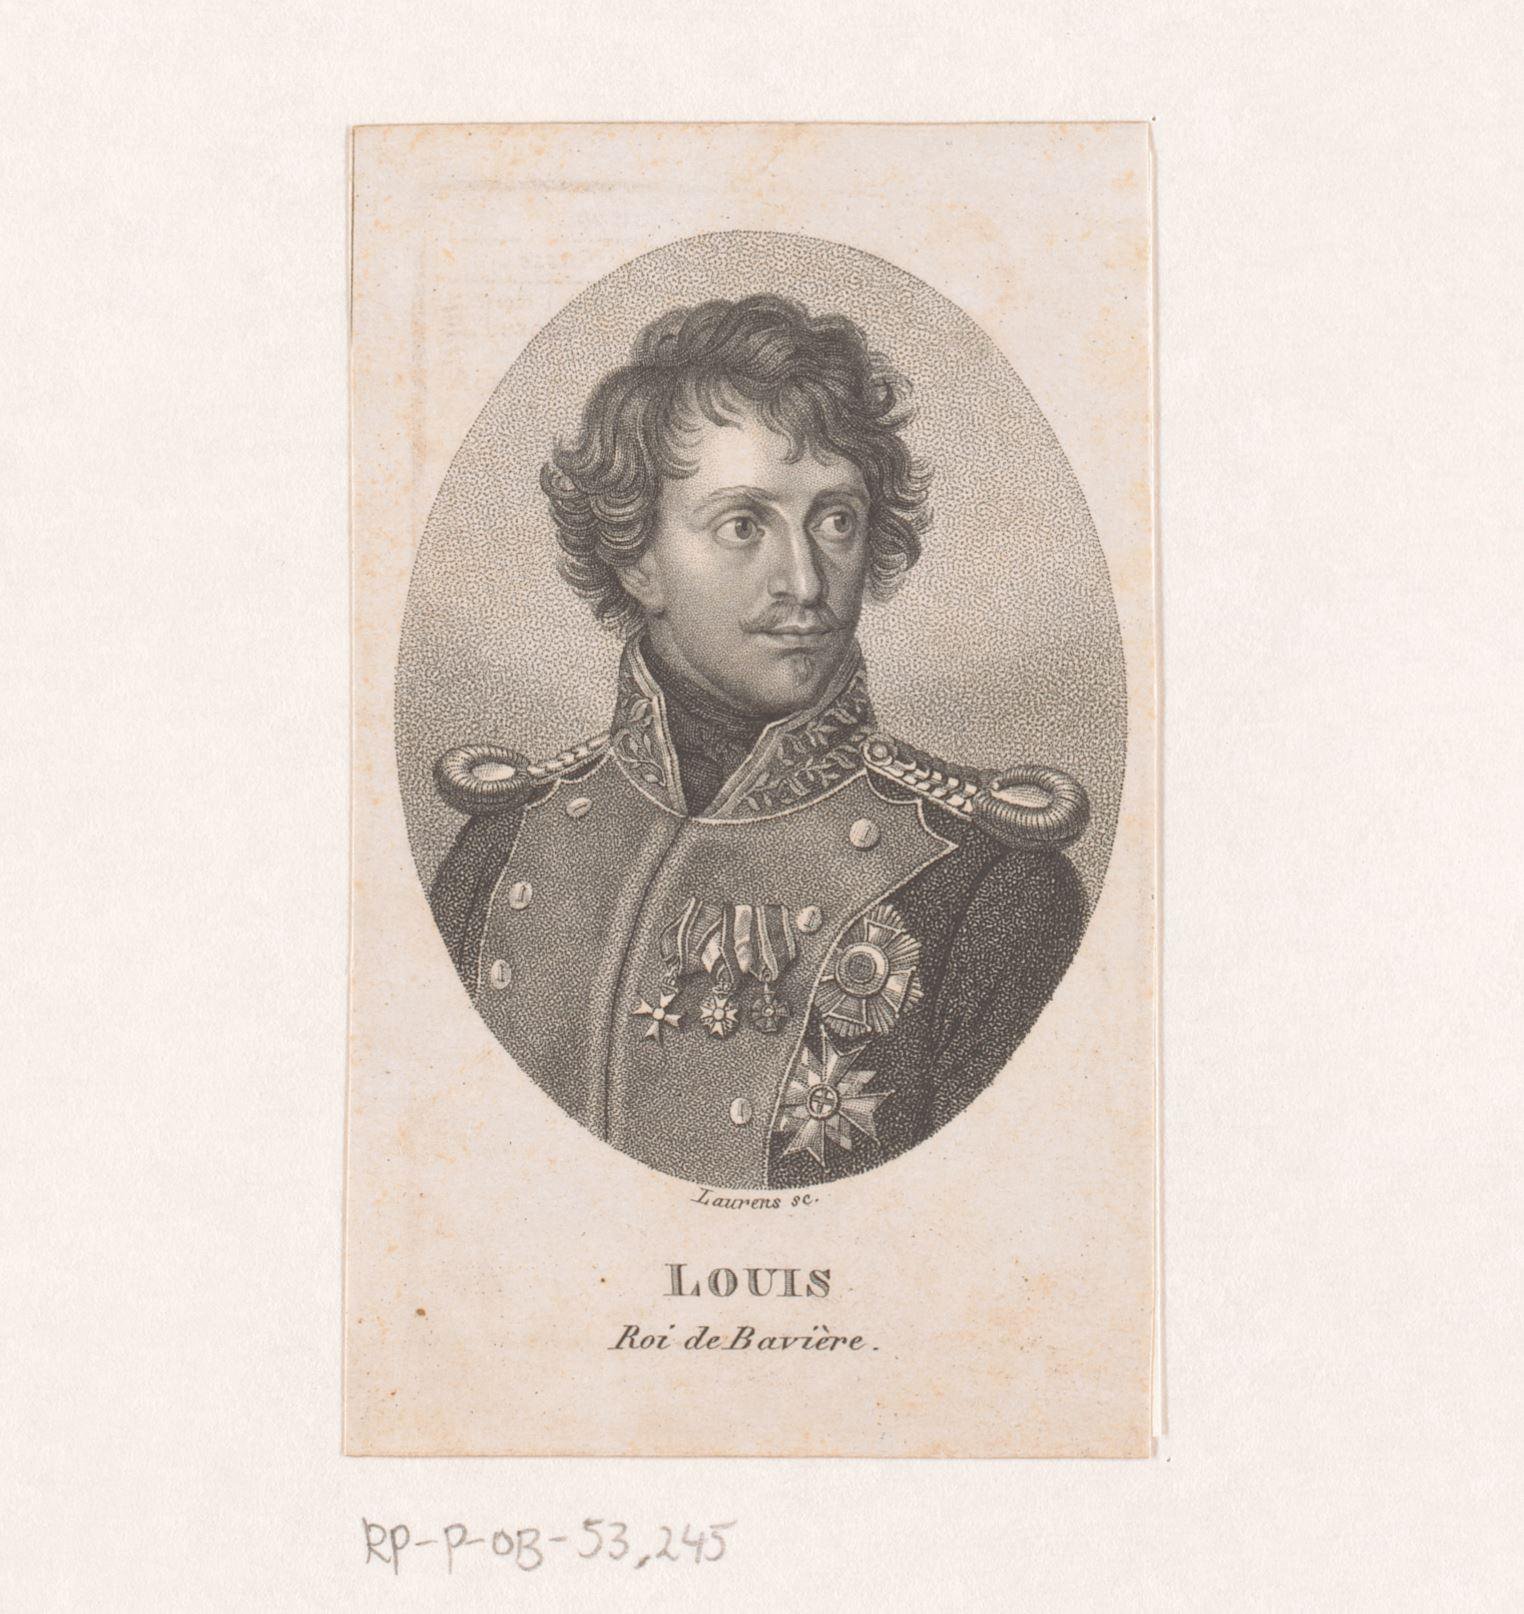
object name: print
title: Portret van Lodewijk I, koning van Beieren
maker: johann daniel laurenz (ii)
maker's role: draughtsman, print maker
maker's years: 1770-1832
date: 1825-1832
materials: paper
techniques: stippling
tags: lodewijk i (koning van beieren), historical persons, king